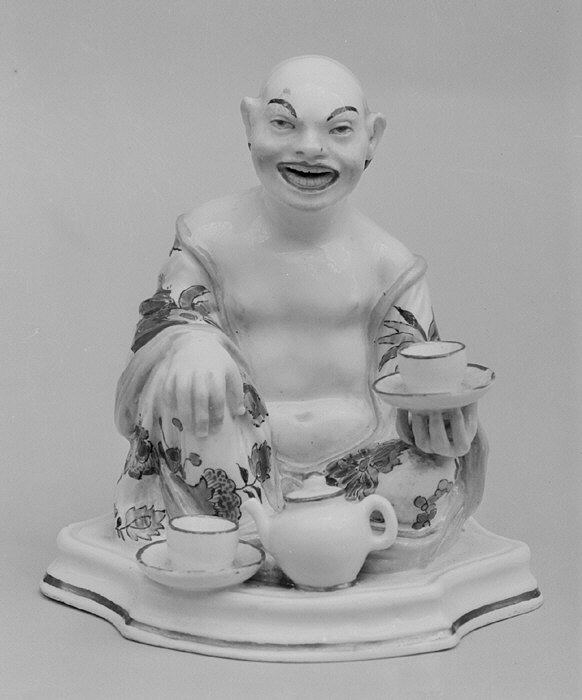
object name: figure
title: Buddhist Divinity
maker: meissen manufactory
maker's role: manufactory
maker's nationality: german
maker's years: 1710-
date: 1735-1740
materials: hard paste porcelain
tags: men,buddhism